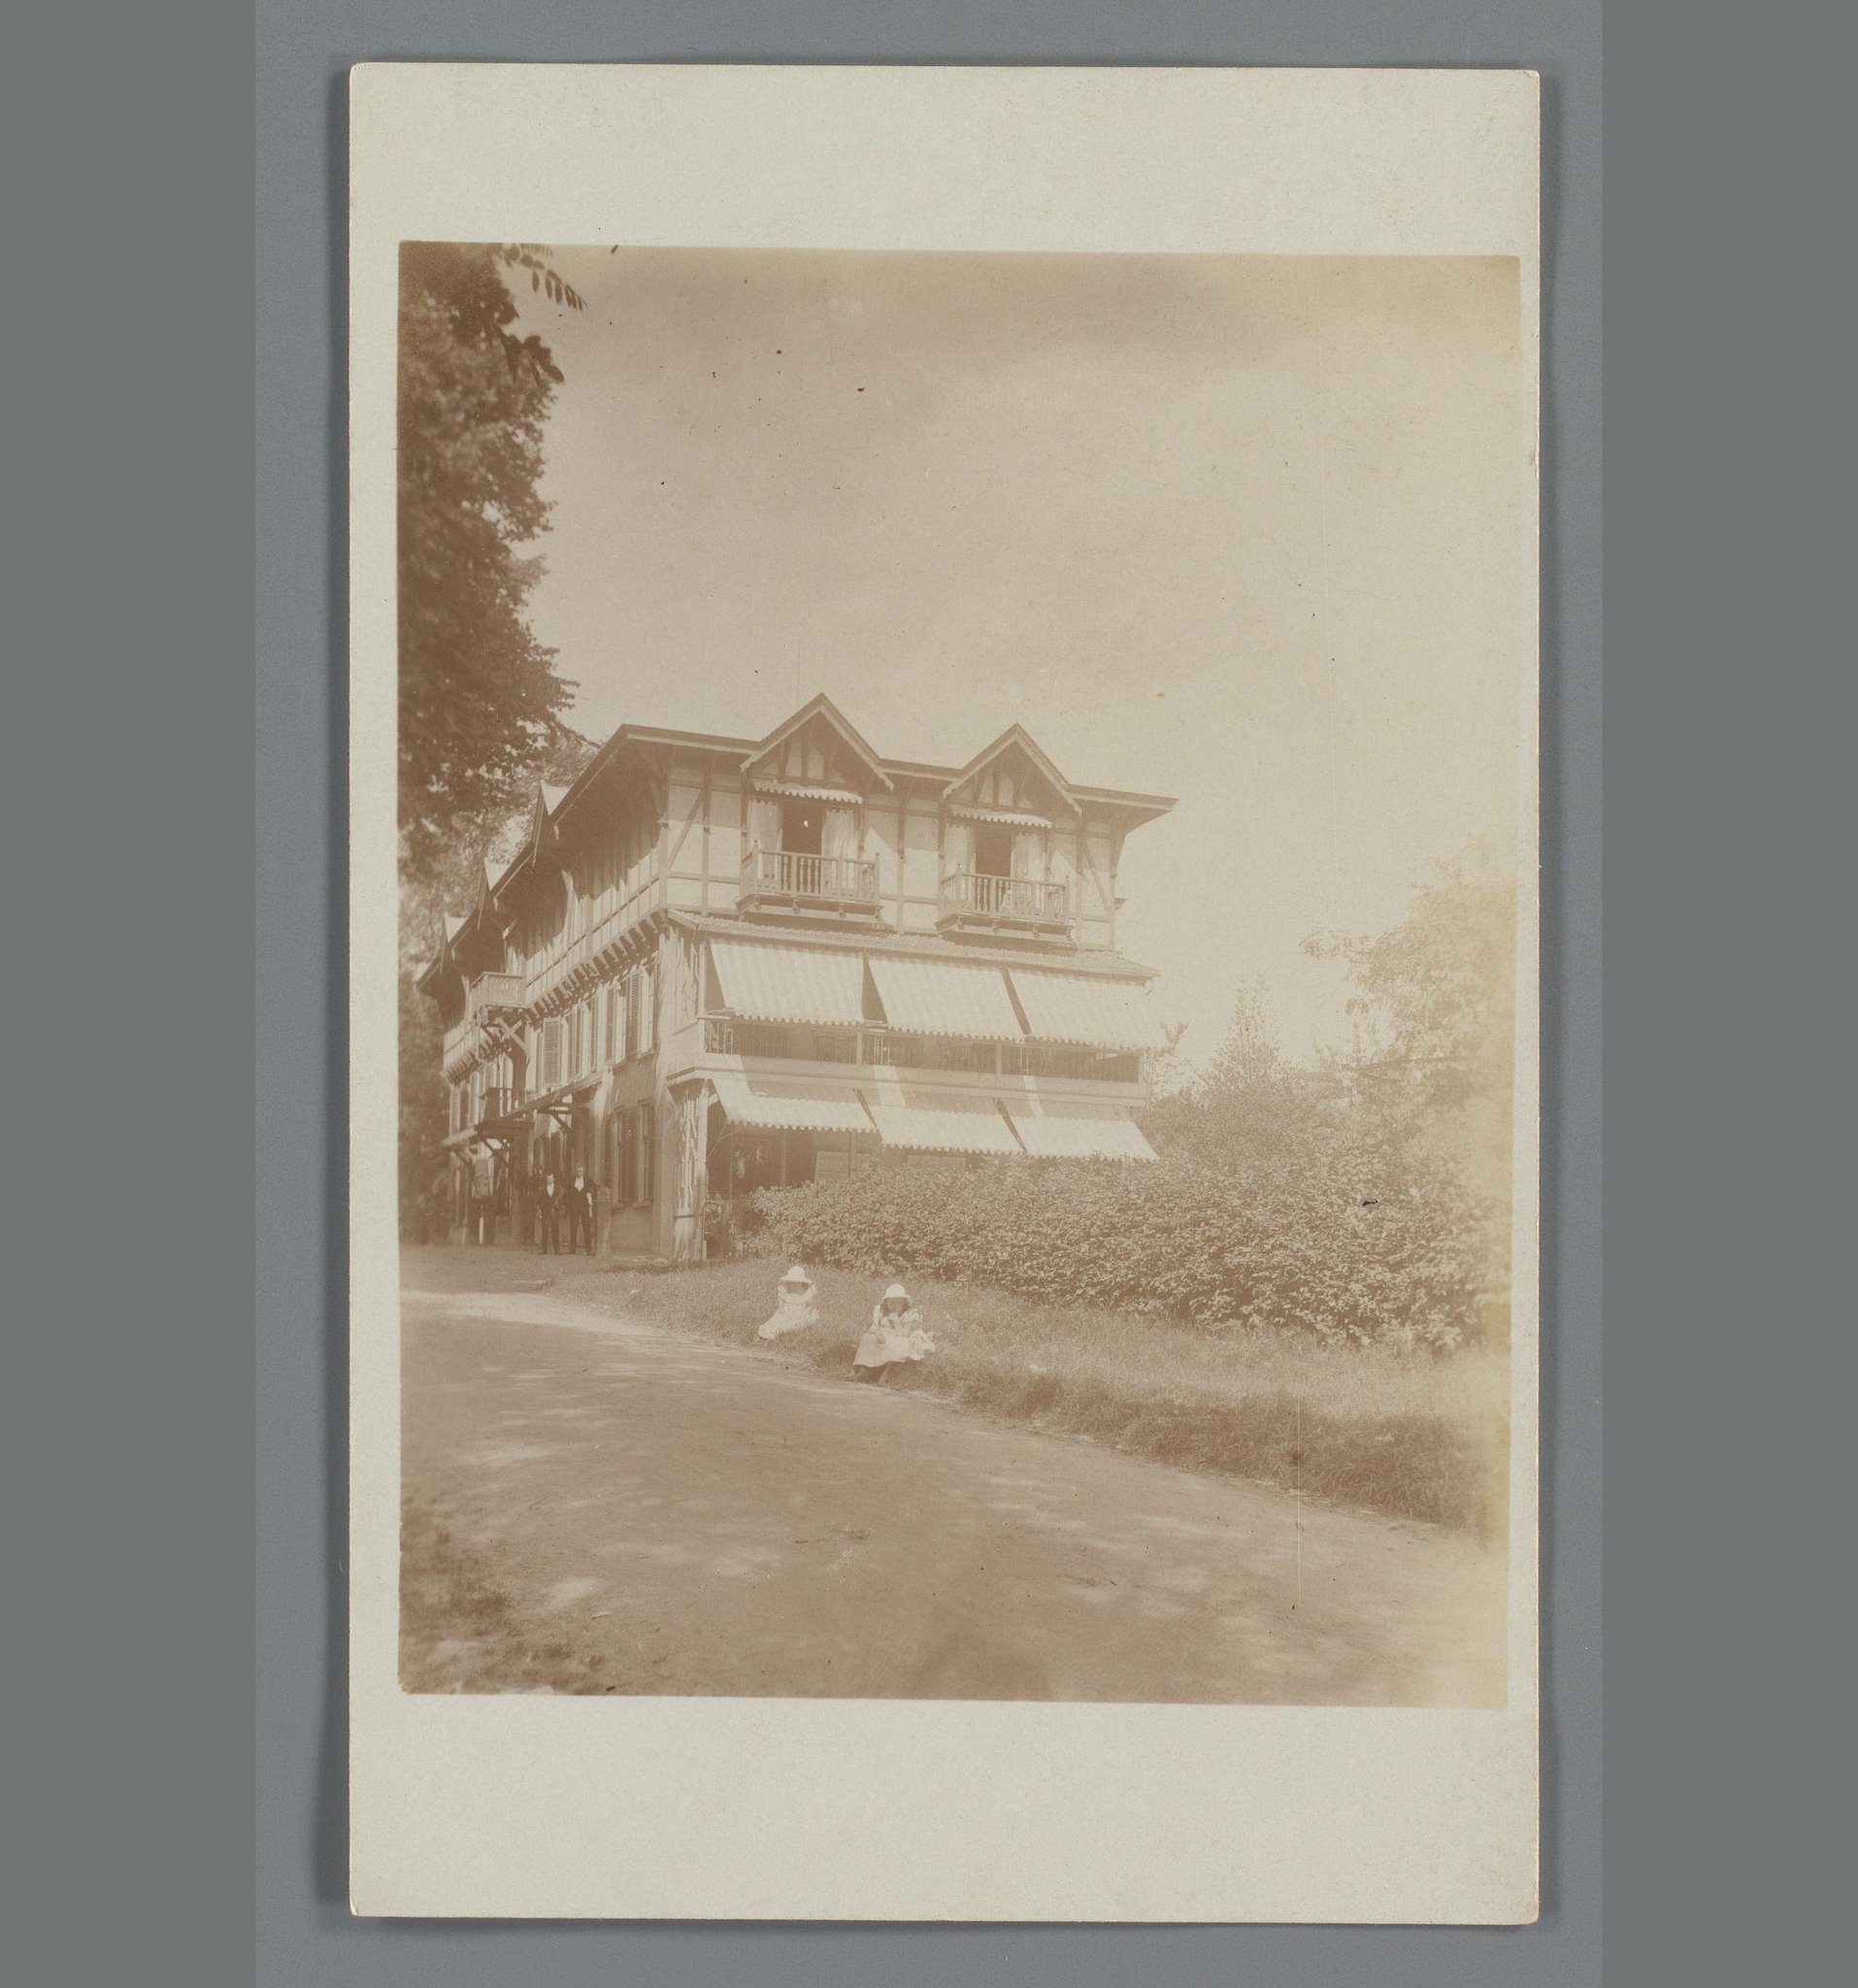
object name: ansichtkaart, prentbriefkaart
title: Johanna (Nan) Vreede en Johanna (Hans) de Jong in het gras bij hotel Oud Berg en Dal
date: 1900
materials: paper, cardboard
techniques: collodion silver print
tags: leiden, johanna petronella lambertina stokhuyzen-de jong (hans), surabaya, johanna elisabeth borgerhoff mulder-vreede (nan), child, sitting on the ground, hotel, hostelry, inn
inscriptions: inscription: ‘Oud Berg en Dal./ Nan en Hans in 't gras’